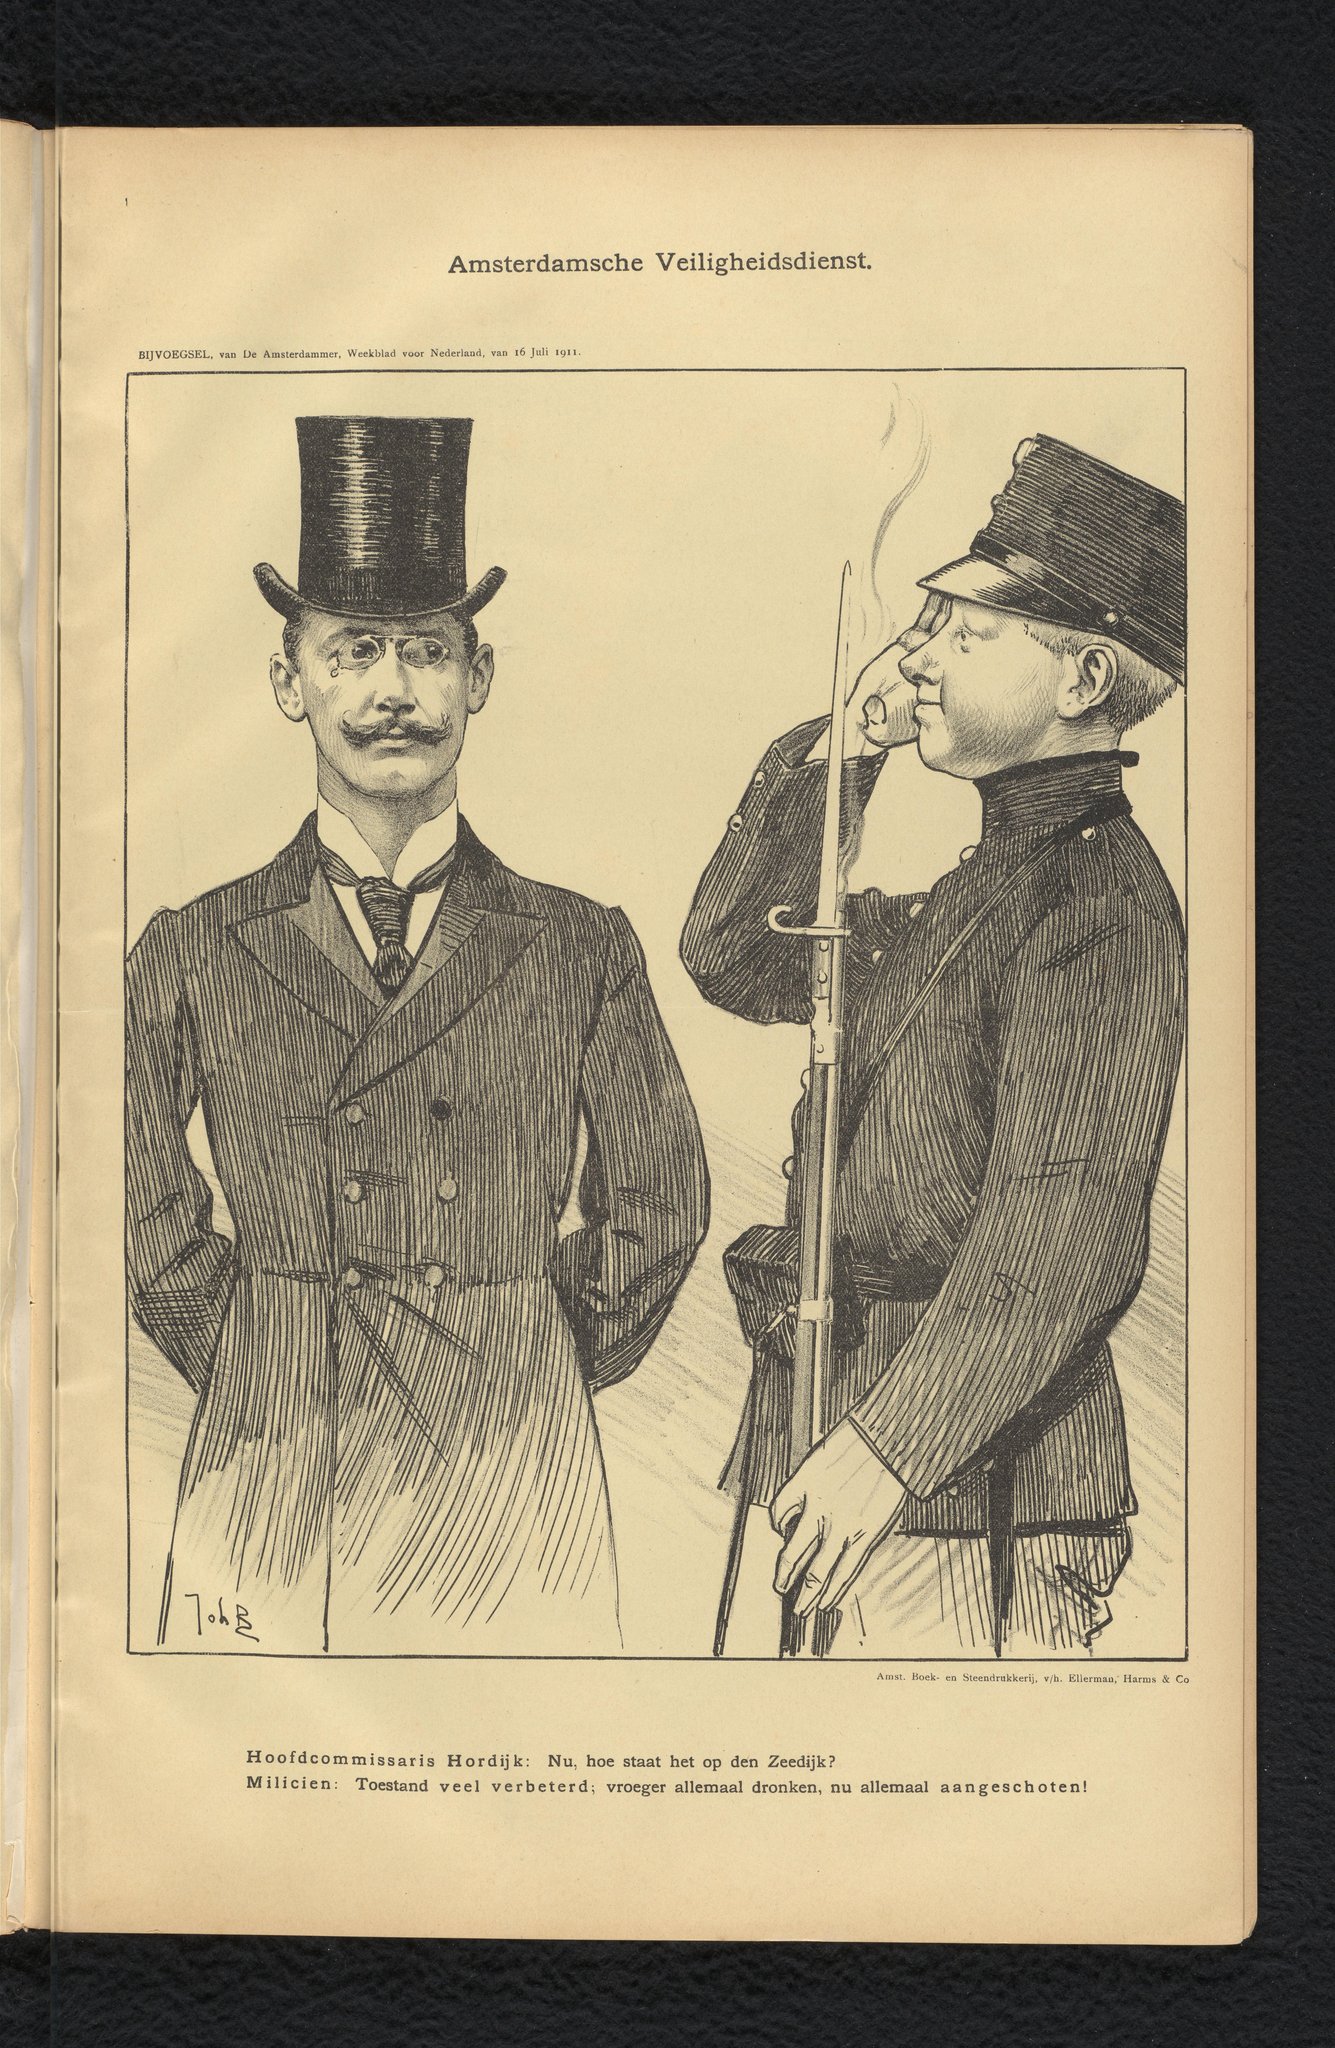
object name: cartoon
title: Amsterdamsche Veiligheidsdienst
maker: johan braakensiek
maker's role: draughtsman, print maker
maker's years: 1858-1940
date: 1911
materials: paper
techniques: lithograph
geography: amsterdam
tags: delft, voorburg, military service, policeman, constable, political caricatures and satires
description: De Amsterdamse hoofdcommissaris van politie Hordijk informeert bij een jonge dienstplichtige met rokende geweer naar de toestand op de Zeedijk.